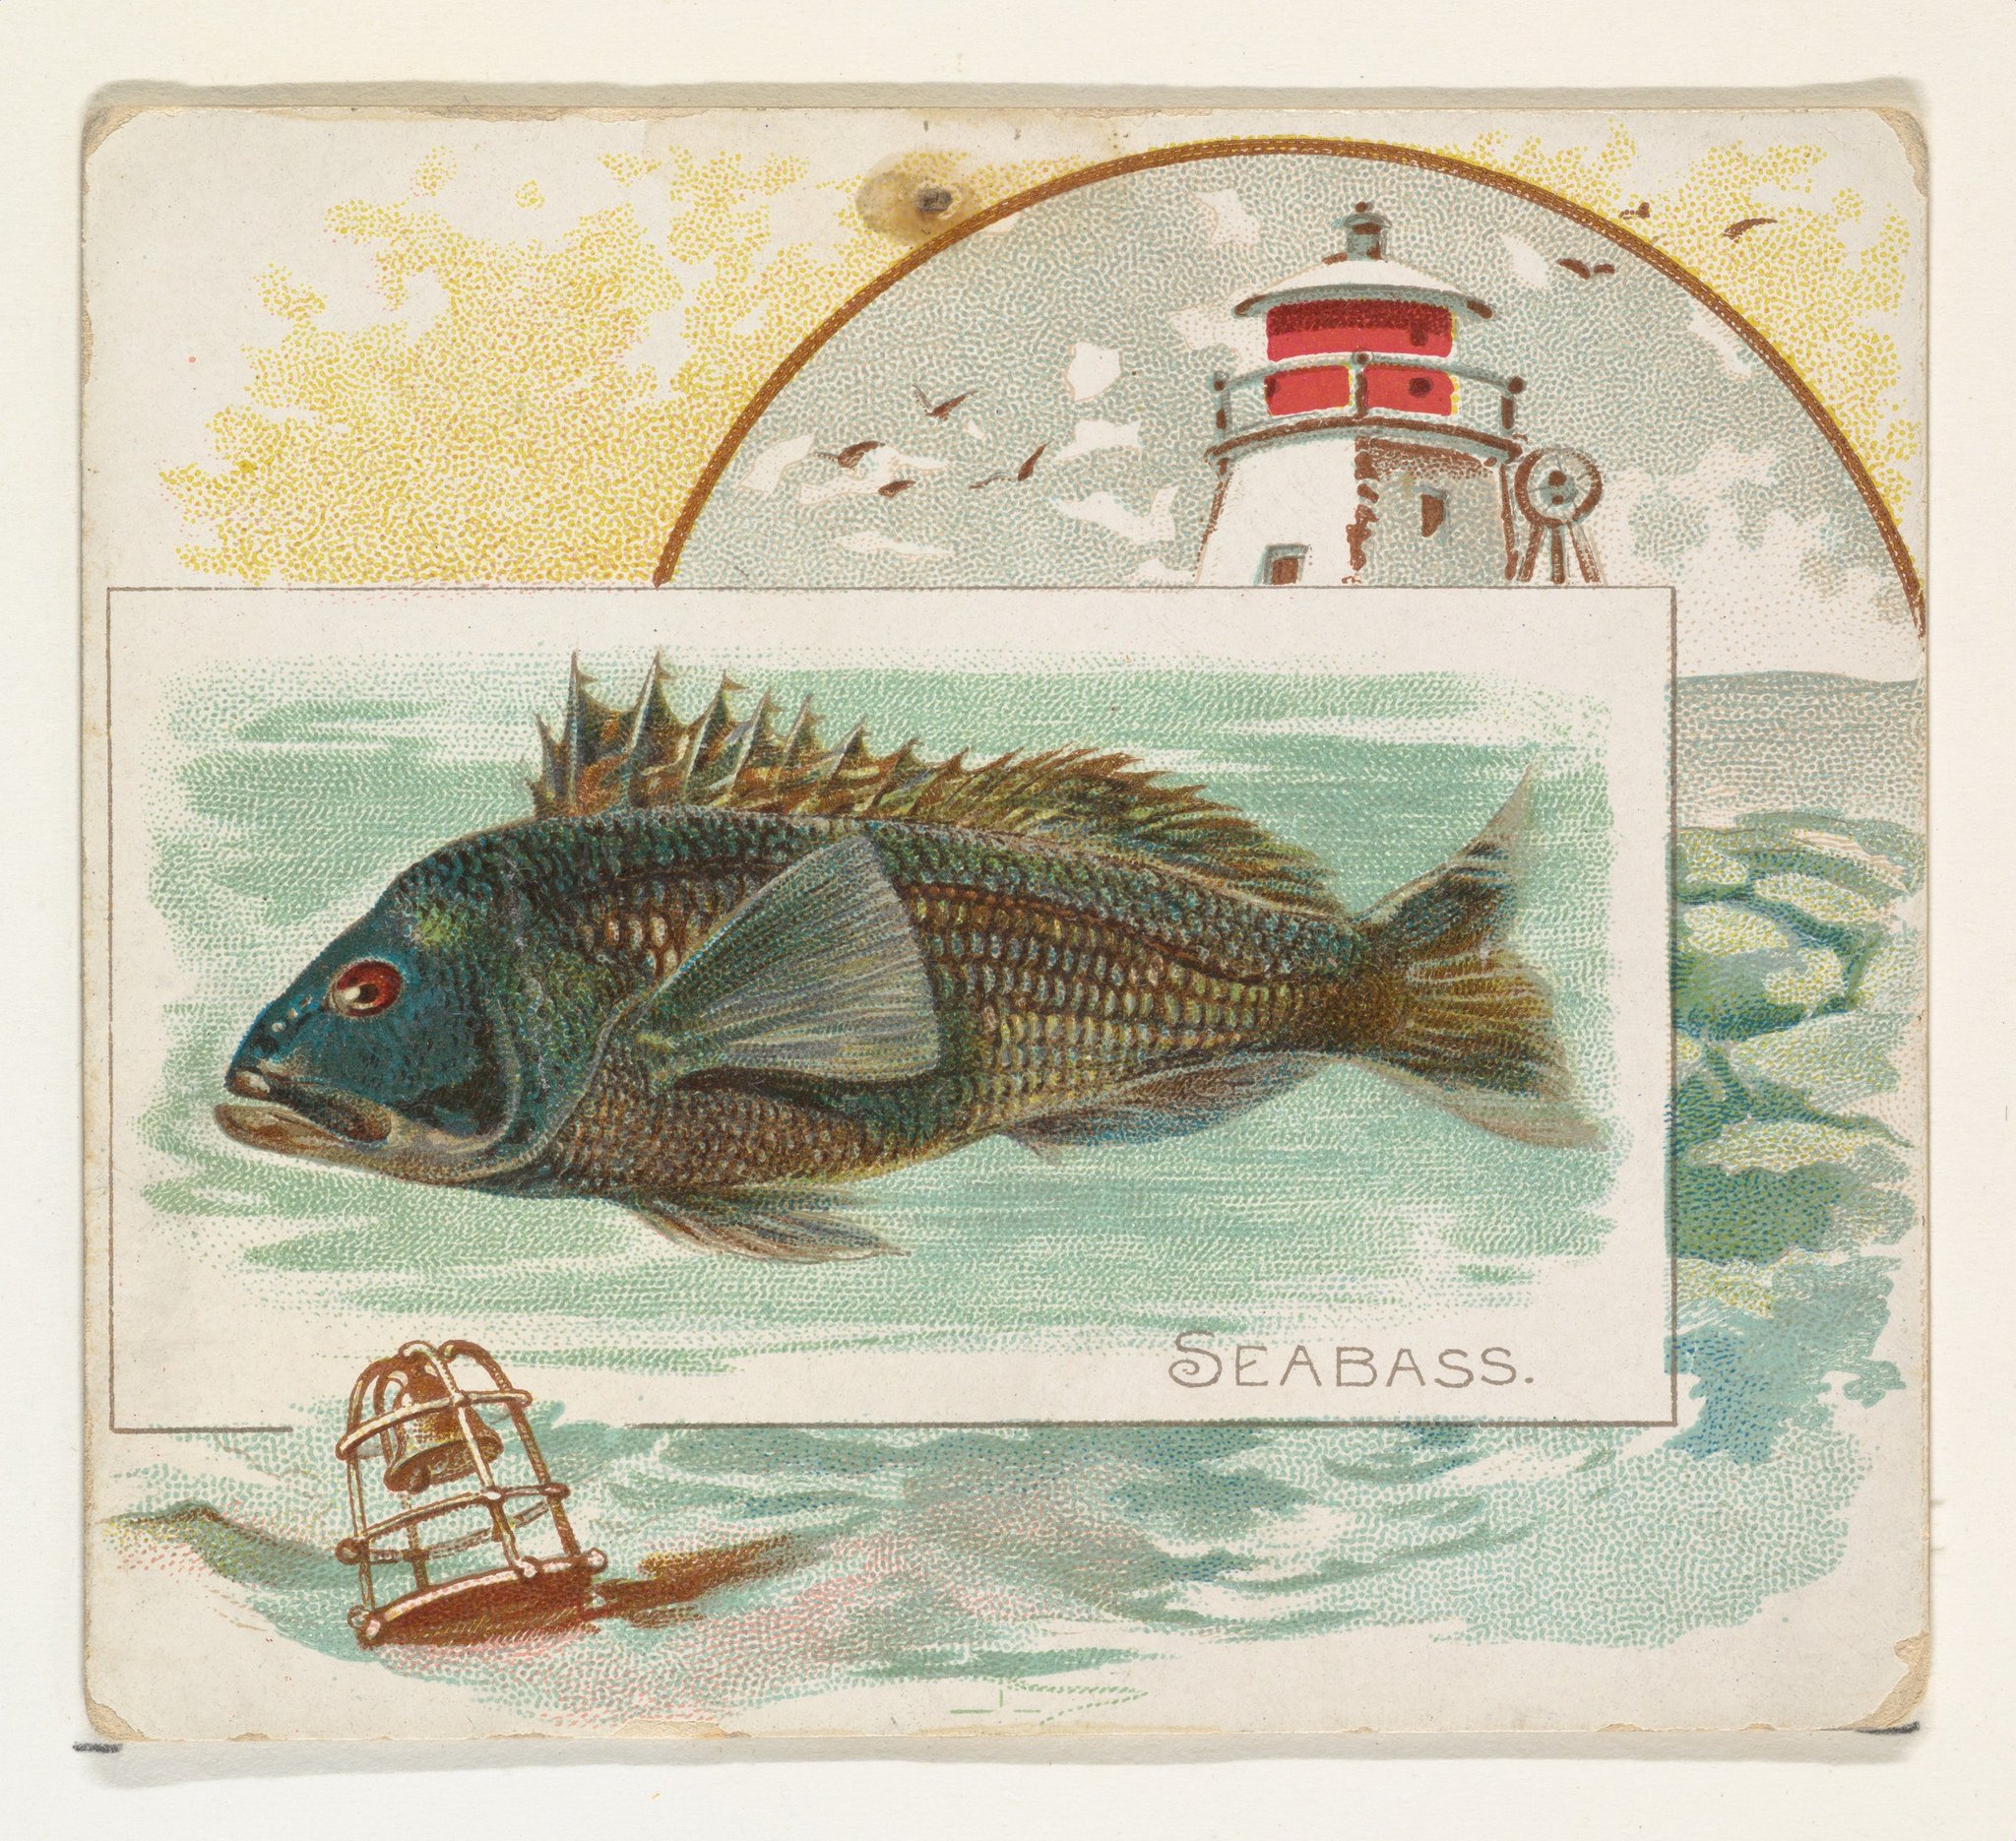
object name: print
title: Sea Bass, from Fish from American Waters series (N39) for Allen & Ginter Cigarettes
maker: allen & ginter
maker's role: publisher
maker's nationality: american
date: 1889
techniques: color lithograph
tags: fish